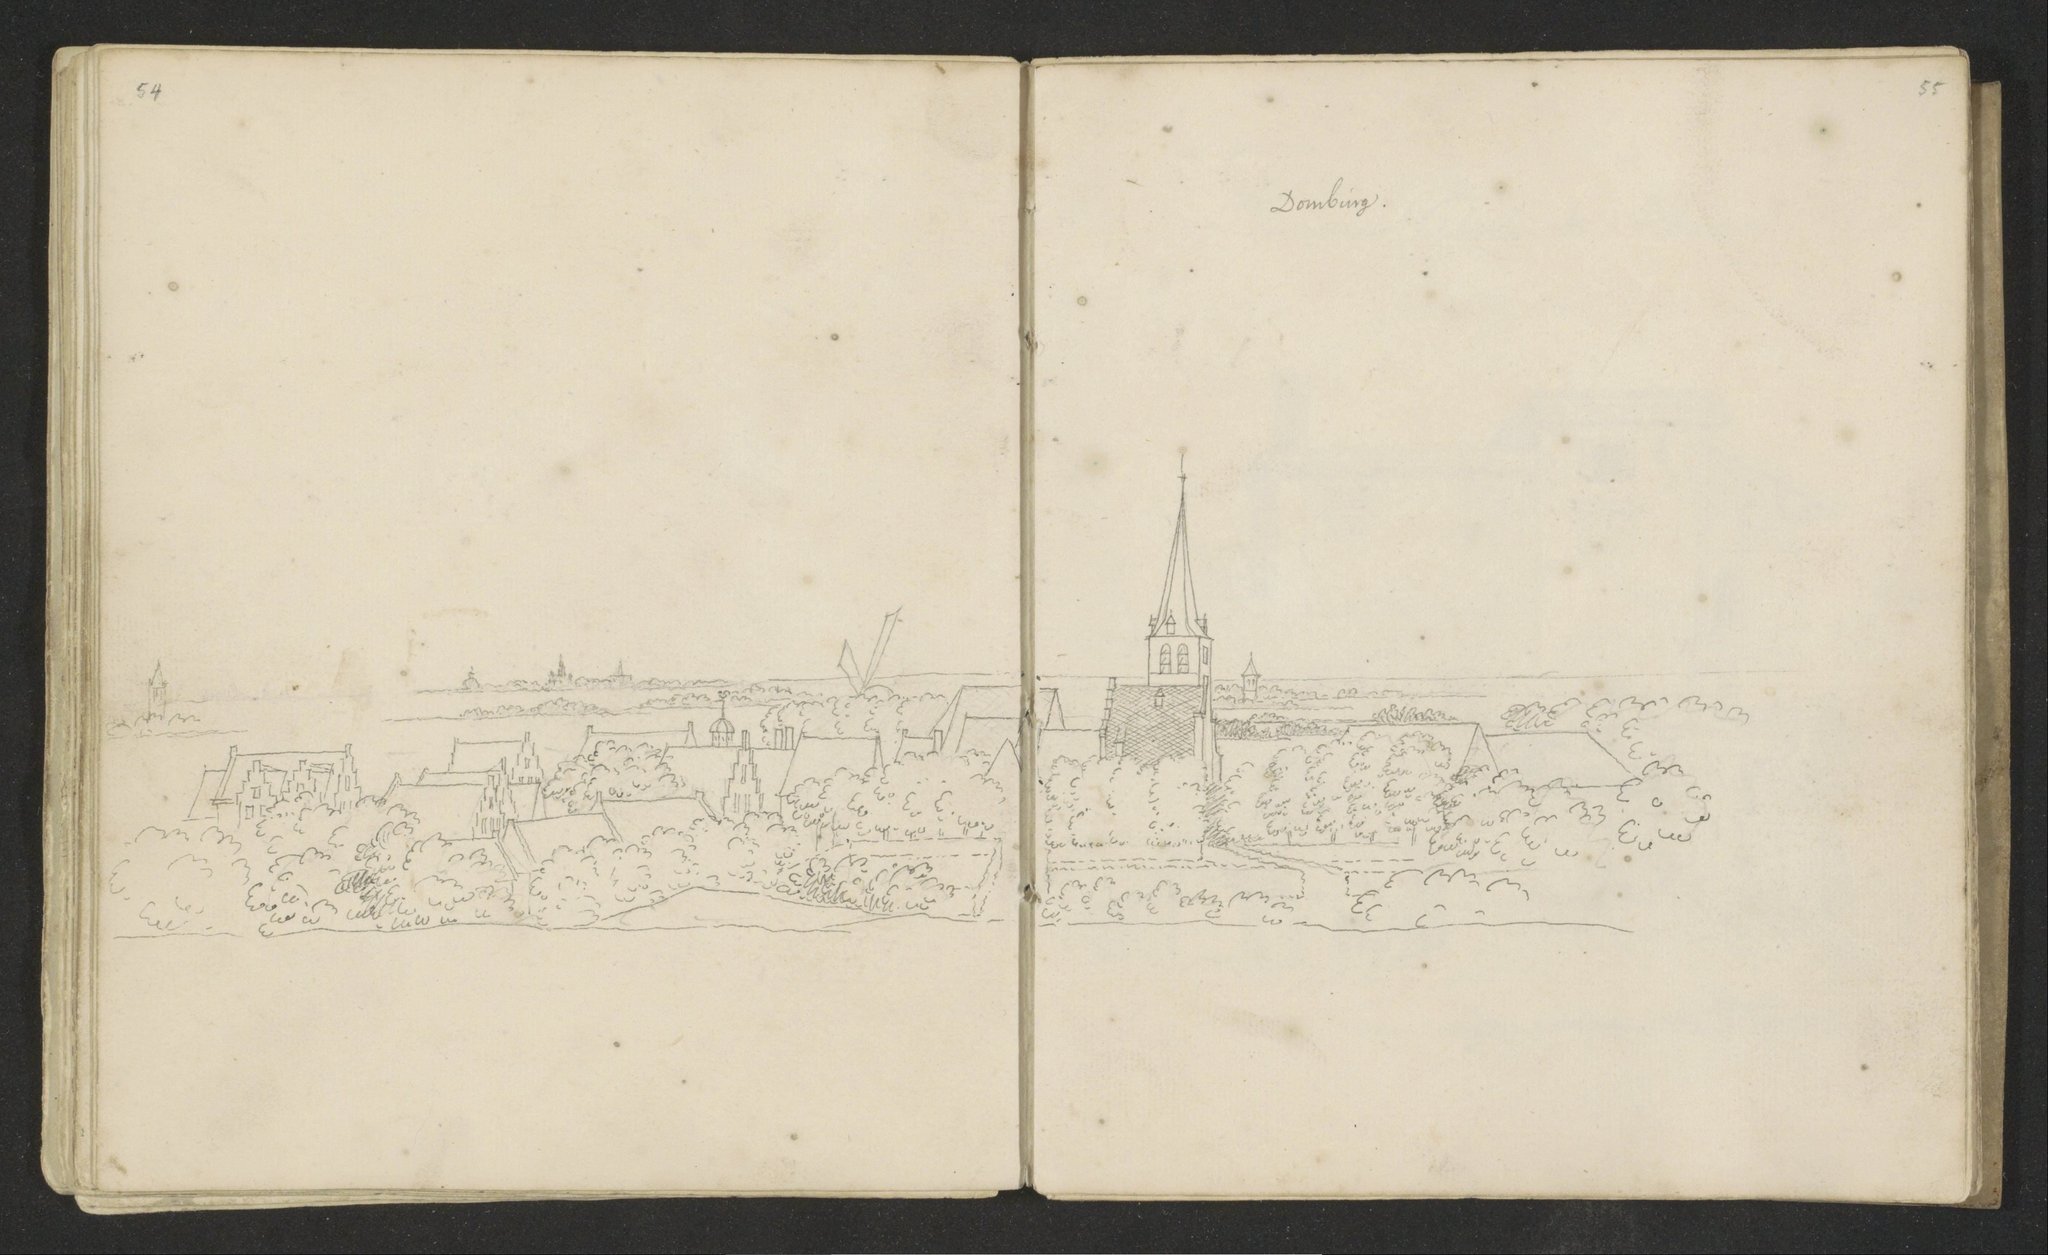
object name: sketchbook leaf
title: Gezicht op Domburg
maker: cornelis pronk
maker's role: draughtsman, painter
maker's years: 1691-1759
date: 1728-1732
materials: ink, paper, pencil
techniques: pen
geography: domburg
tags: prospect of city, town panorama, silhouette of city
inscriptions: annotation: ‘Domburg’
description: Bladzijde 54 en 55 uit een schetsboek met 96 bladzijden.